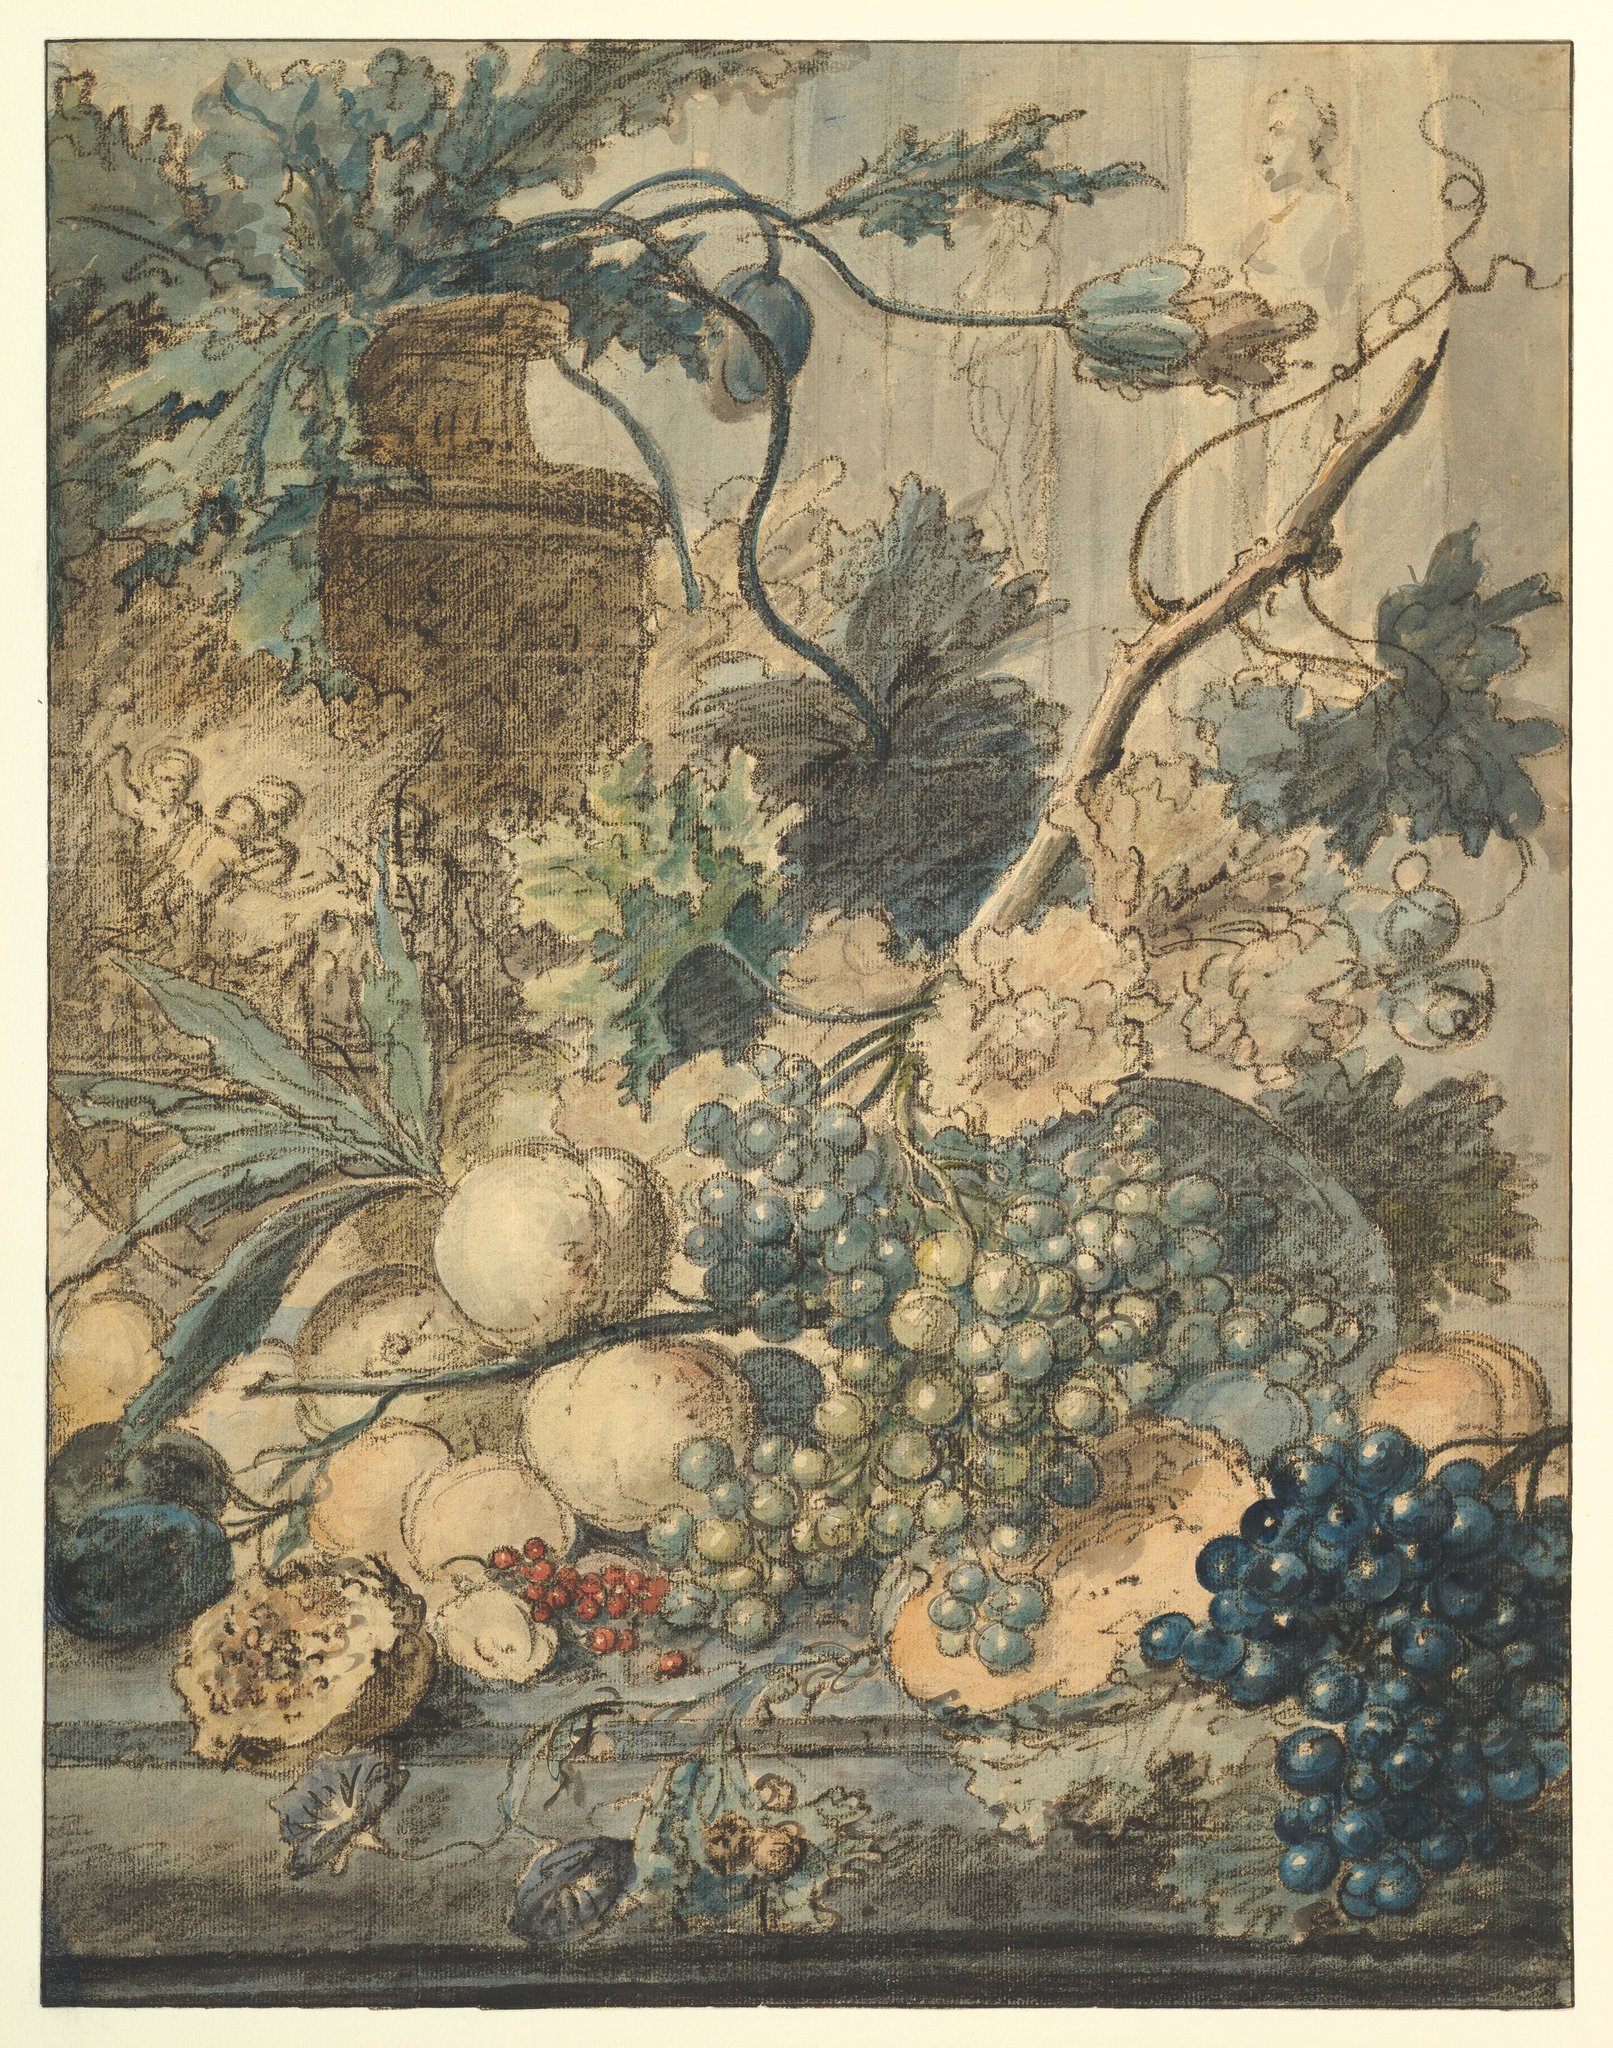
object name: drawing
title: Still Life with Fruit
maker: jan van huysum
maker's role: artist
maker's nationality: dutch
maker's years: 1682-1749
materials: chalk, ink, watercolor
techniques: pen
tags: fruit,grapes,still life